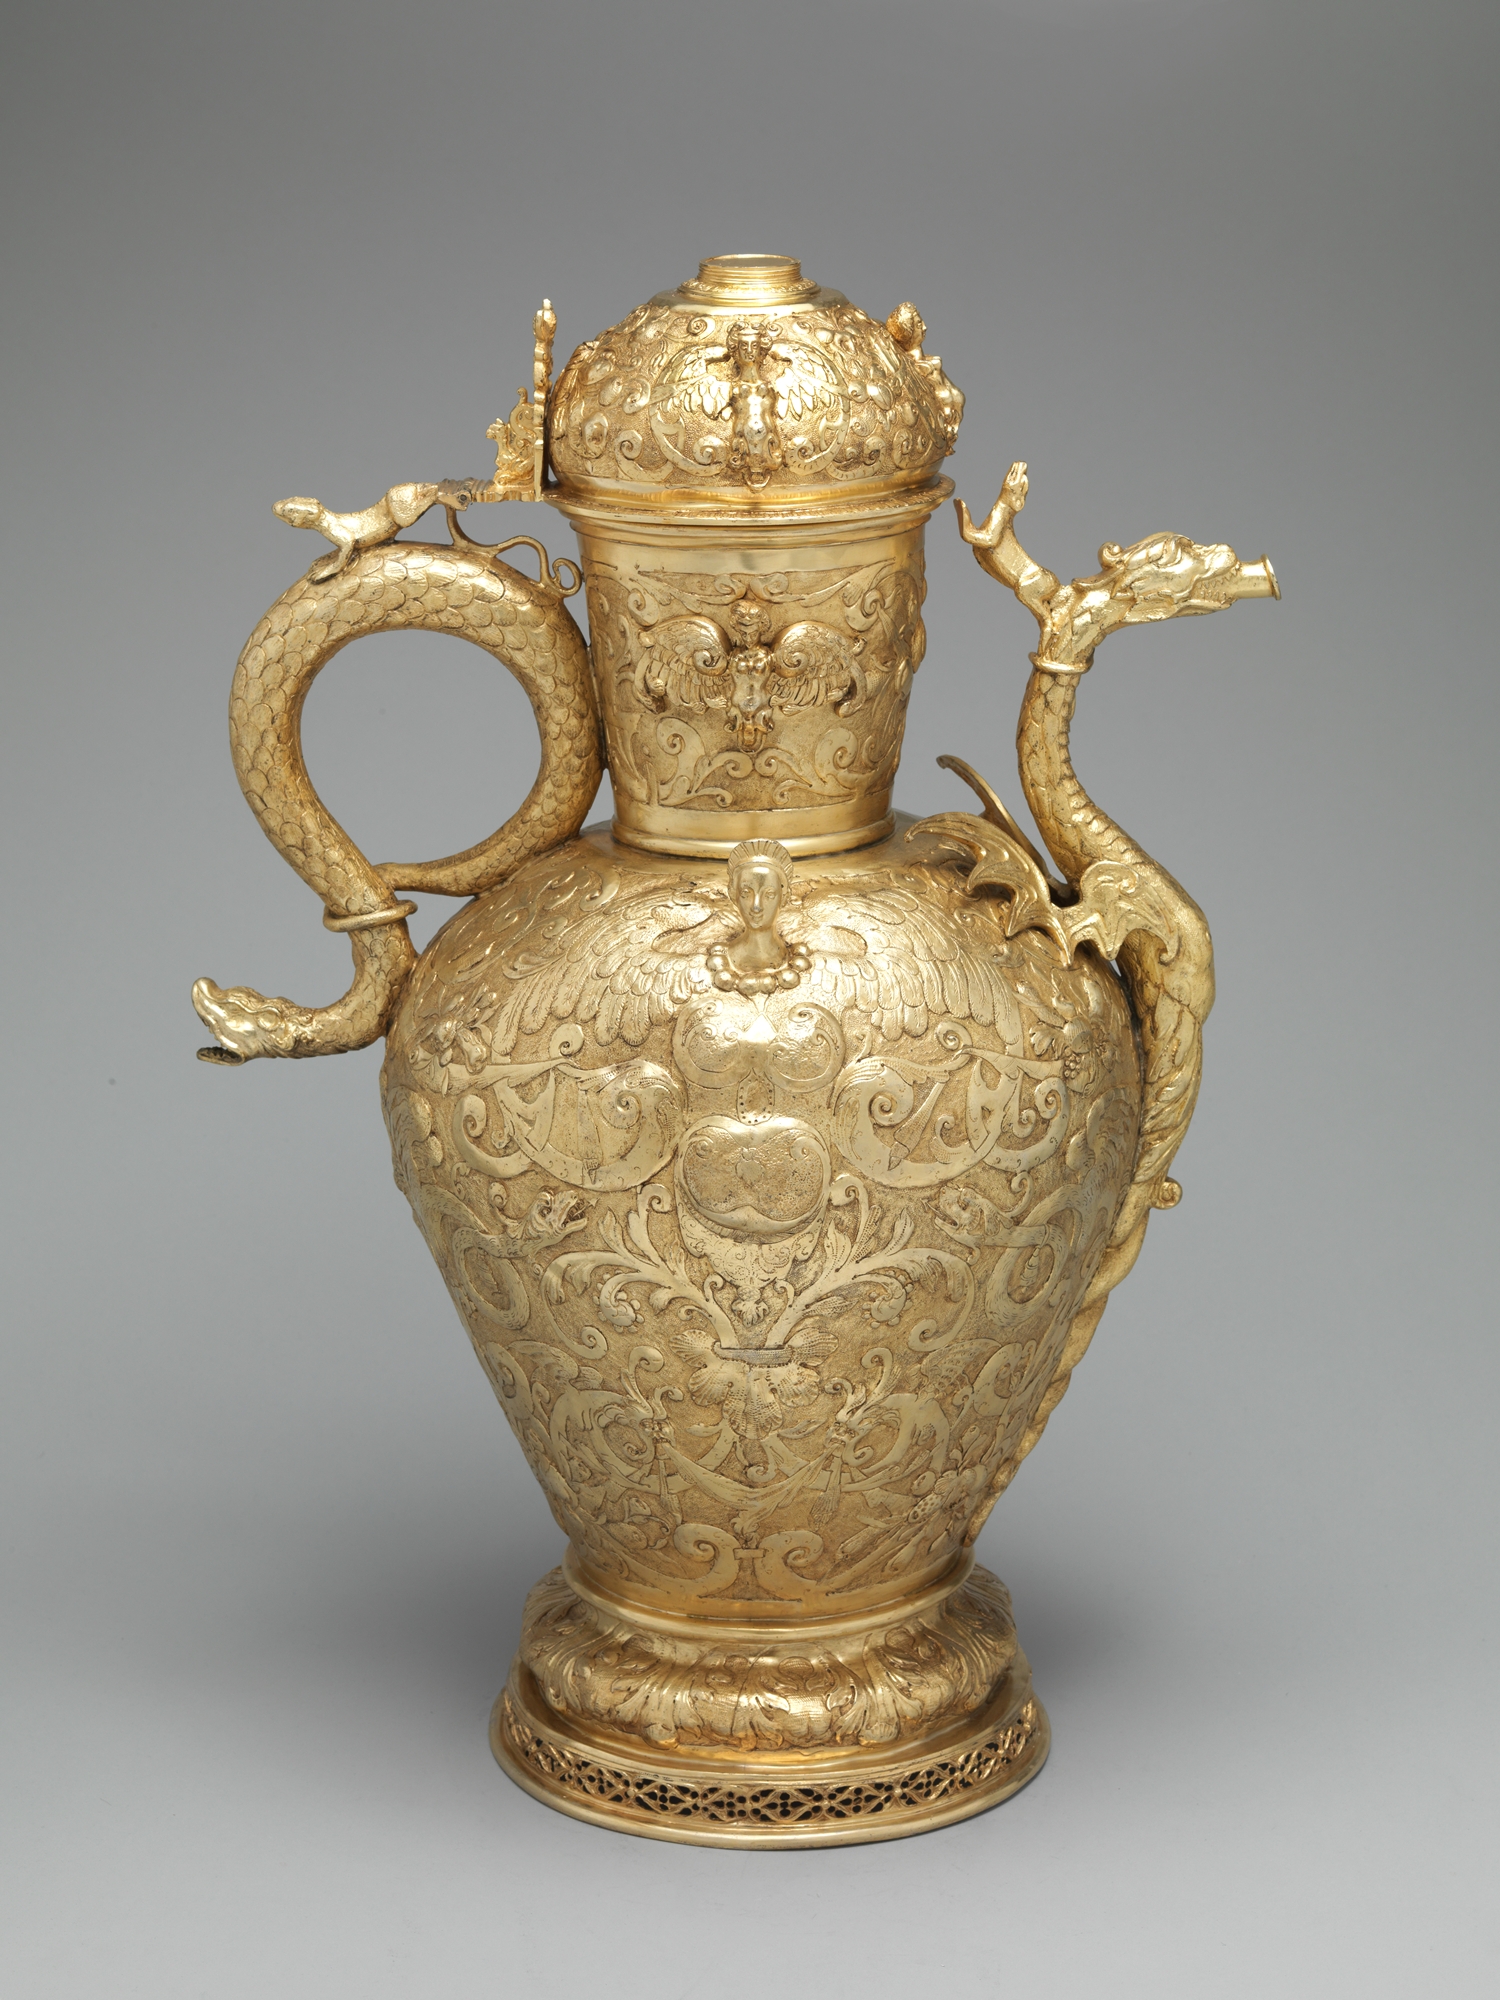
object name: jug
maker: elkington & co.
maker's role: manufacturer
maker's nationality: british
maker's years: 1829-1963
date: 1801-1900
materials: copper, gilt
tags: faces,dragons,snakes